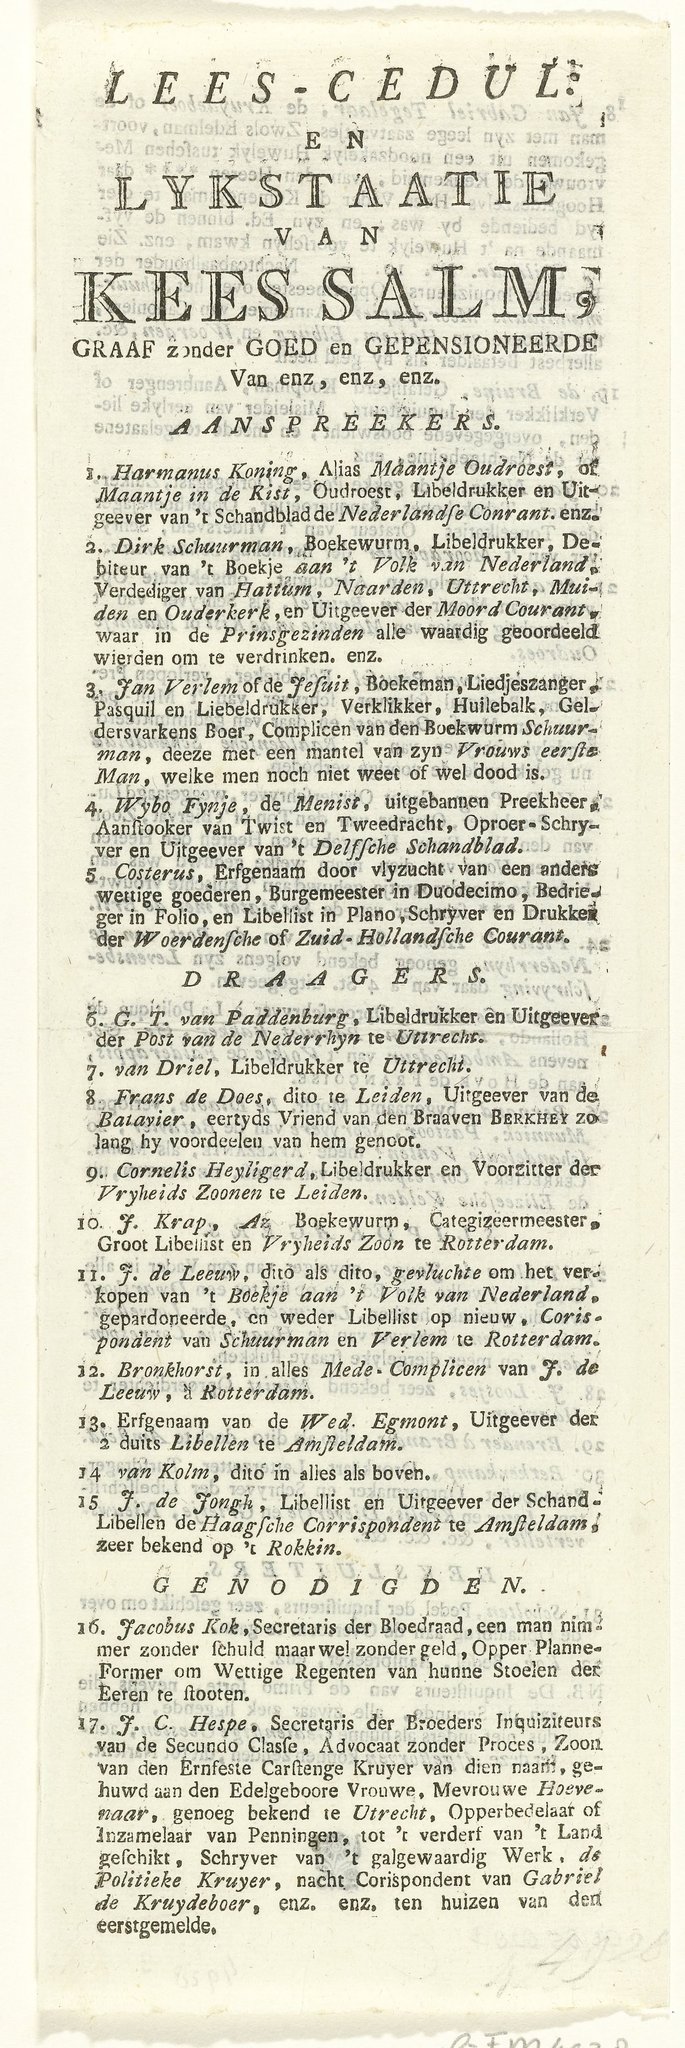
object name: text sheet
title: Lees-Cedul en Lykstaatie van Kees Salm (...)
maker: Anonymous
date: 1787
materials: paper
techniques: letterpress printing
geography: northern netherlands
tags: rijngraaf van salm frederik iii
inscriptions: collector's mark: Lugt 2228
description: Tekstblad met een lijst van de namen van de personen aangeduid met de nummers 1-32 in de begrafenisstoet in de spotprent op de Rijngraaf van Salm. Bedrukt op beide zijden.